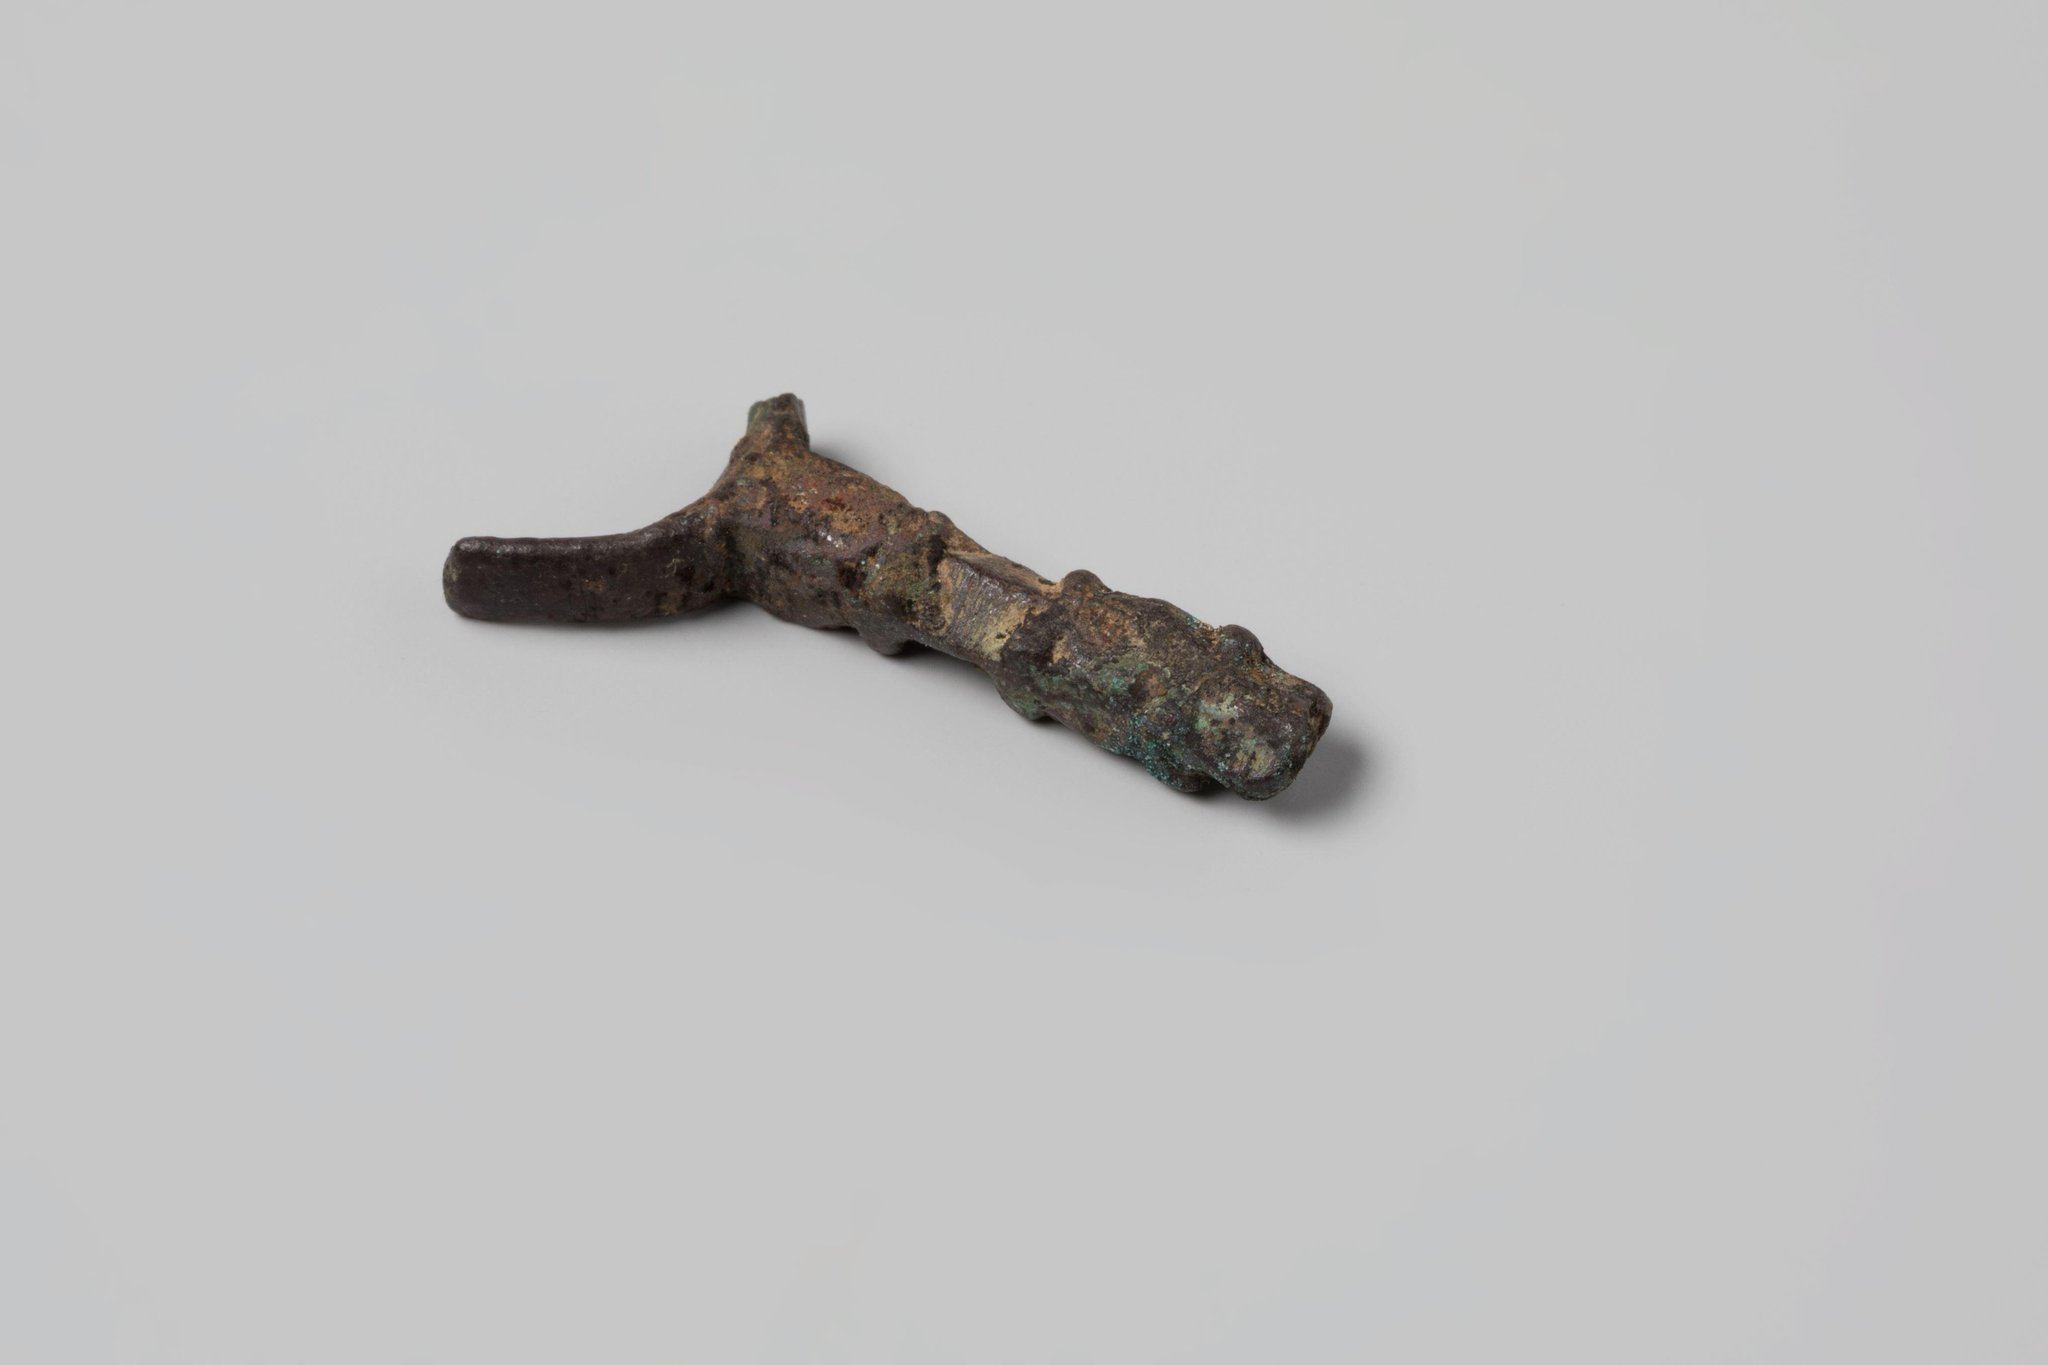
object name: pin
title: Fragment speld uit het wrak van de Oost-Indiëvaarder Hollandia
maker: Anonymous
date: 1700-1743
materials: copper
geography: netherlands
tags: verenigde oostindische compagnie, hollandia (schip), annet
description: Tools and instruments, sewing and sailmaking, pin; fragm of shaft with bow, id. NG 1980-27H3265.